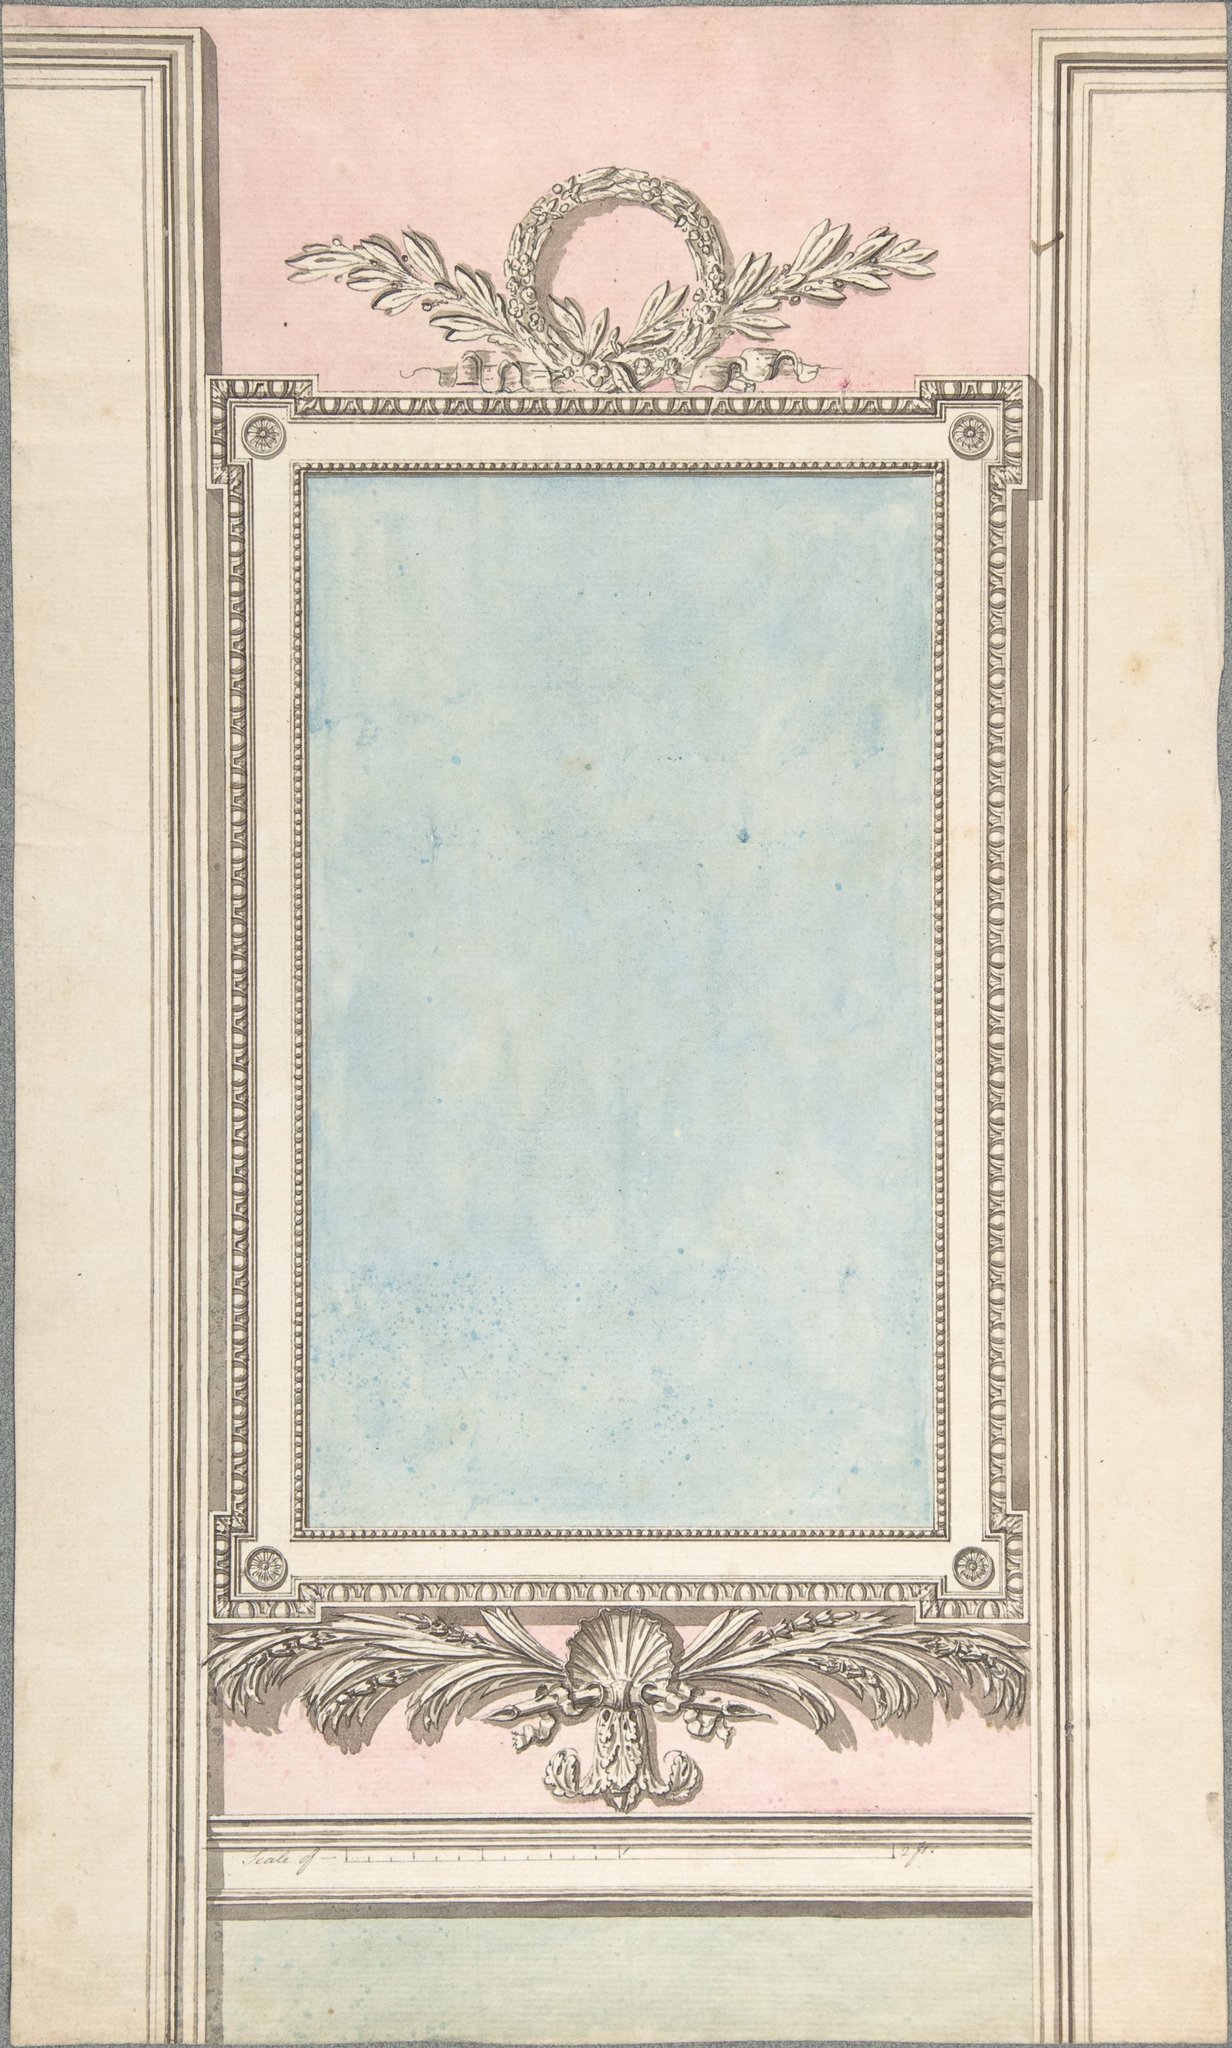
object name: drawing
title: Design for a Mirror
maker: john yenn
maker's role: artist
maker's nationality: british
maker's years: 1750-1821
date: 1767-1833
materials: ink, watercolor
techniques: brush, pen, wash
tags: mirrors